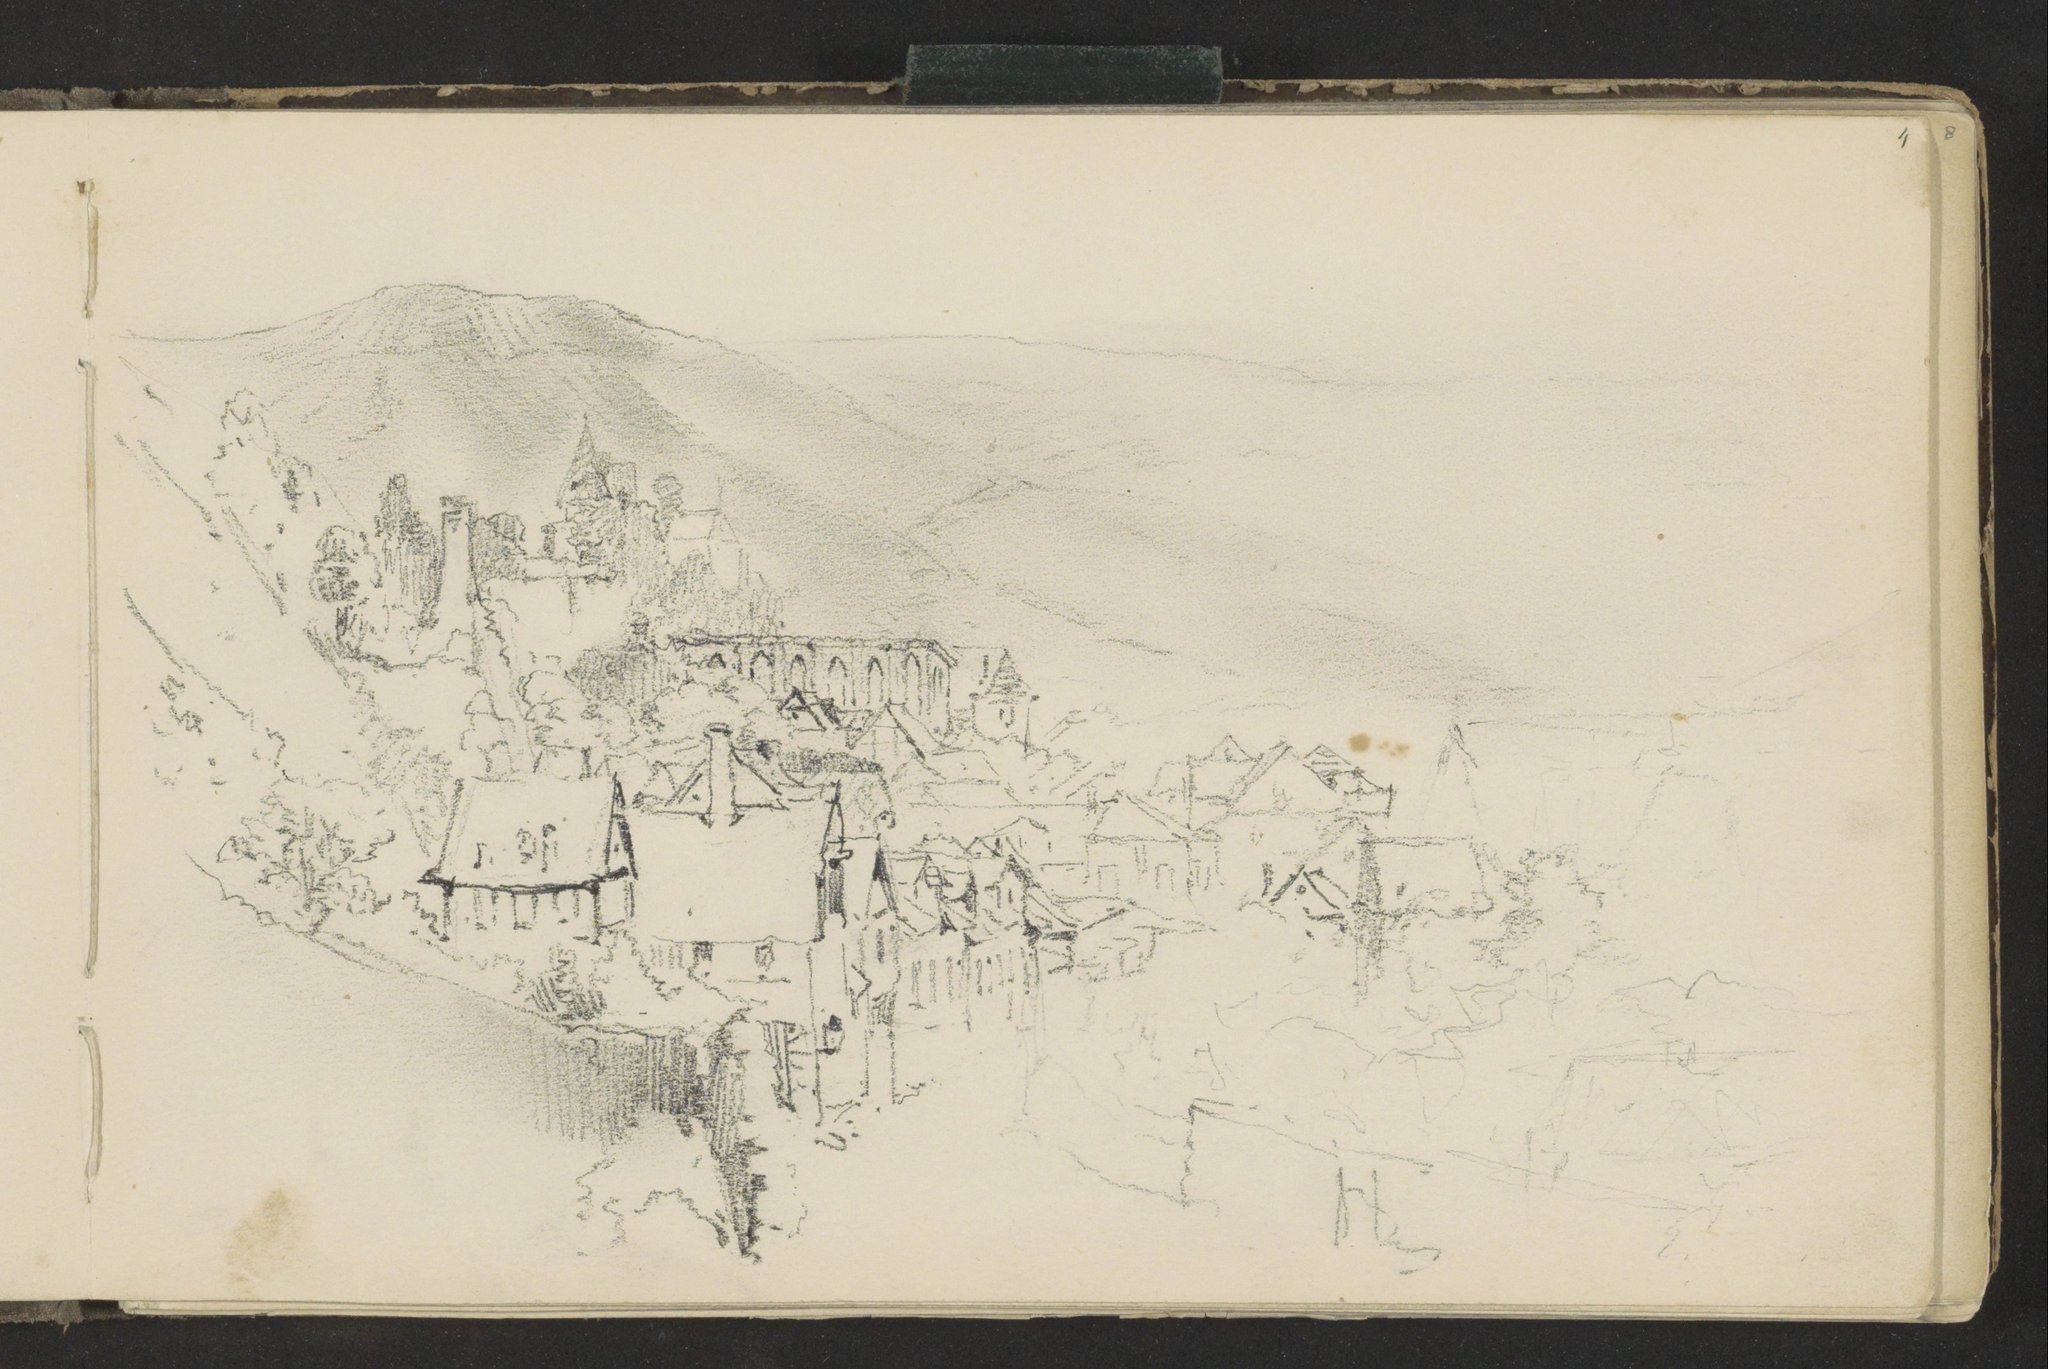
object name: sketchbook leaf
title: Gezicht op een stad aan de voet van een berg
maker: maria vos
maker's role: draughtsman, painter, print maker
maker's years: 1824-1906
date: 1871-1878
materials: paper, pencil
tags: city-view, and landscape with man-made constructions, mountains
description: Blad 4 recto uit een schetsboek met 45 bladen.